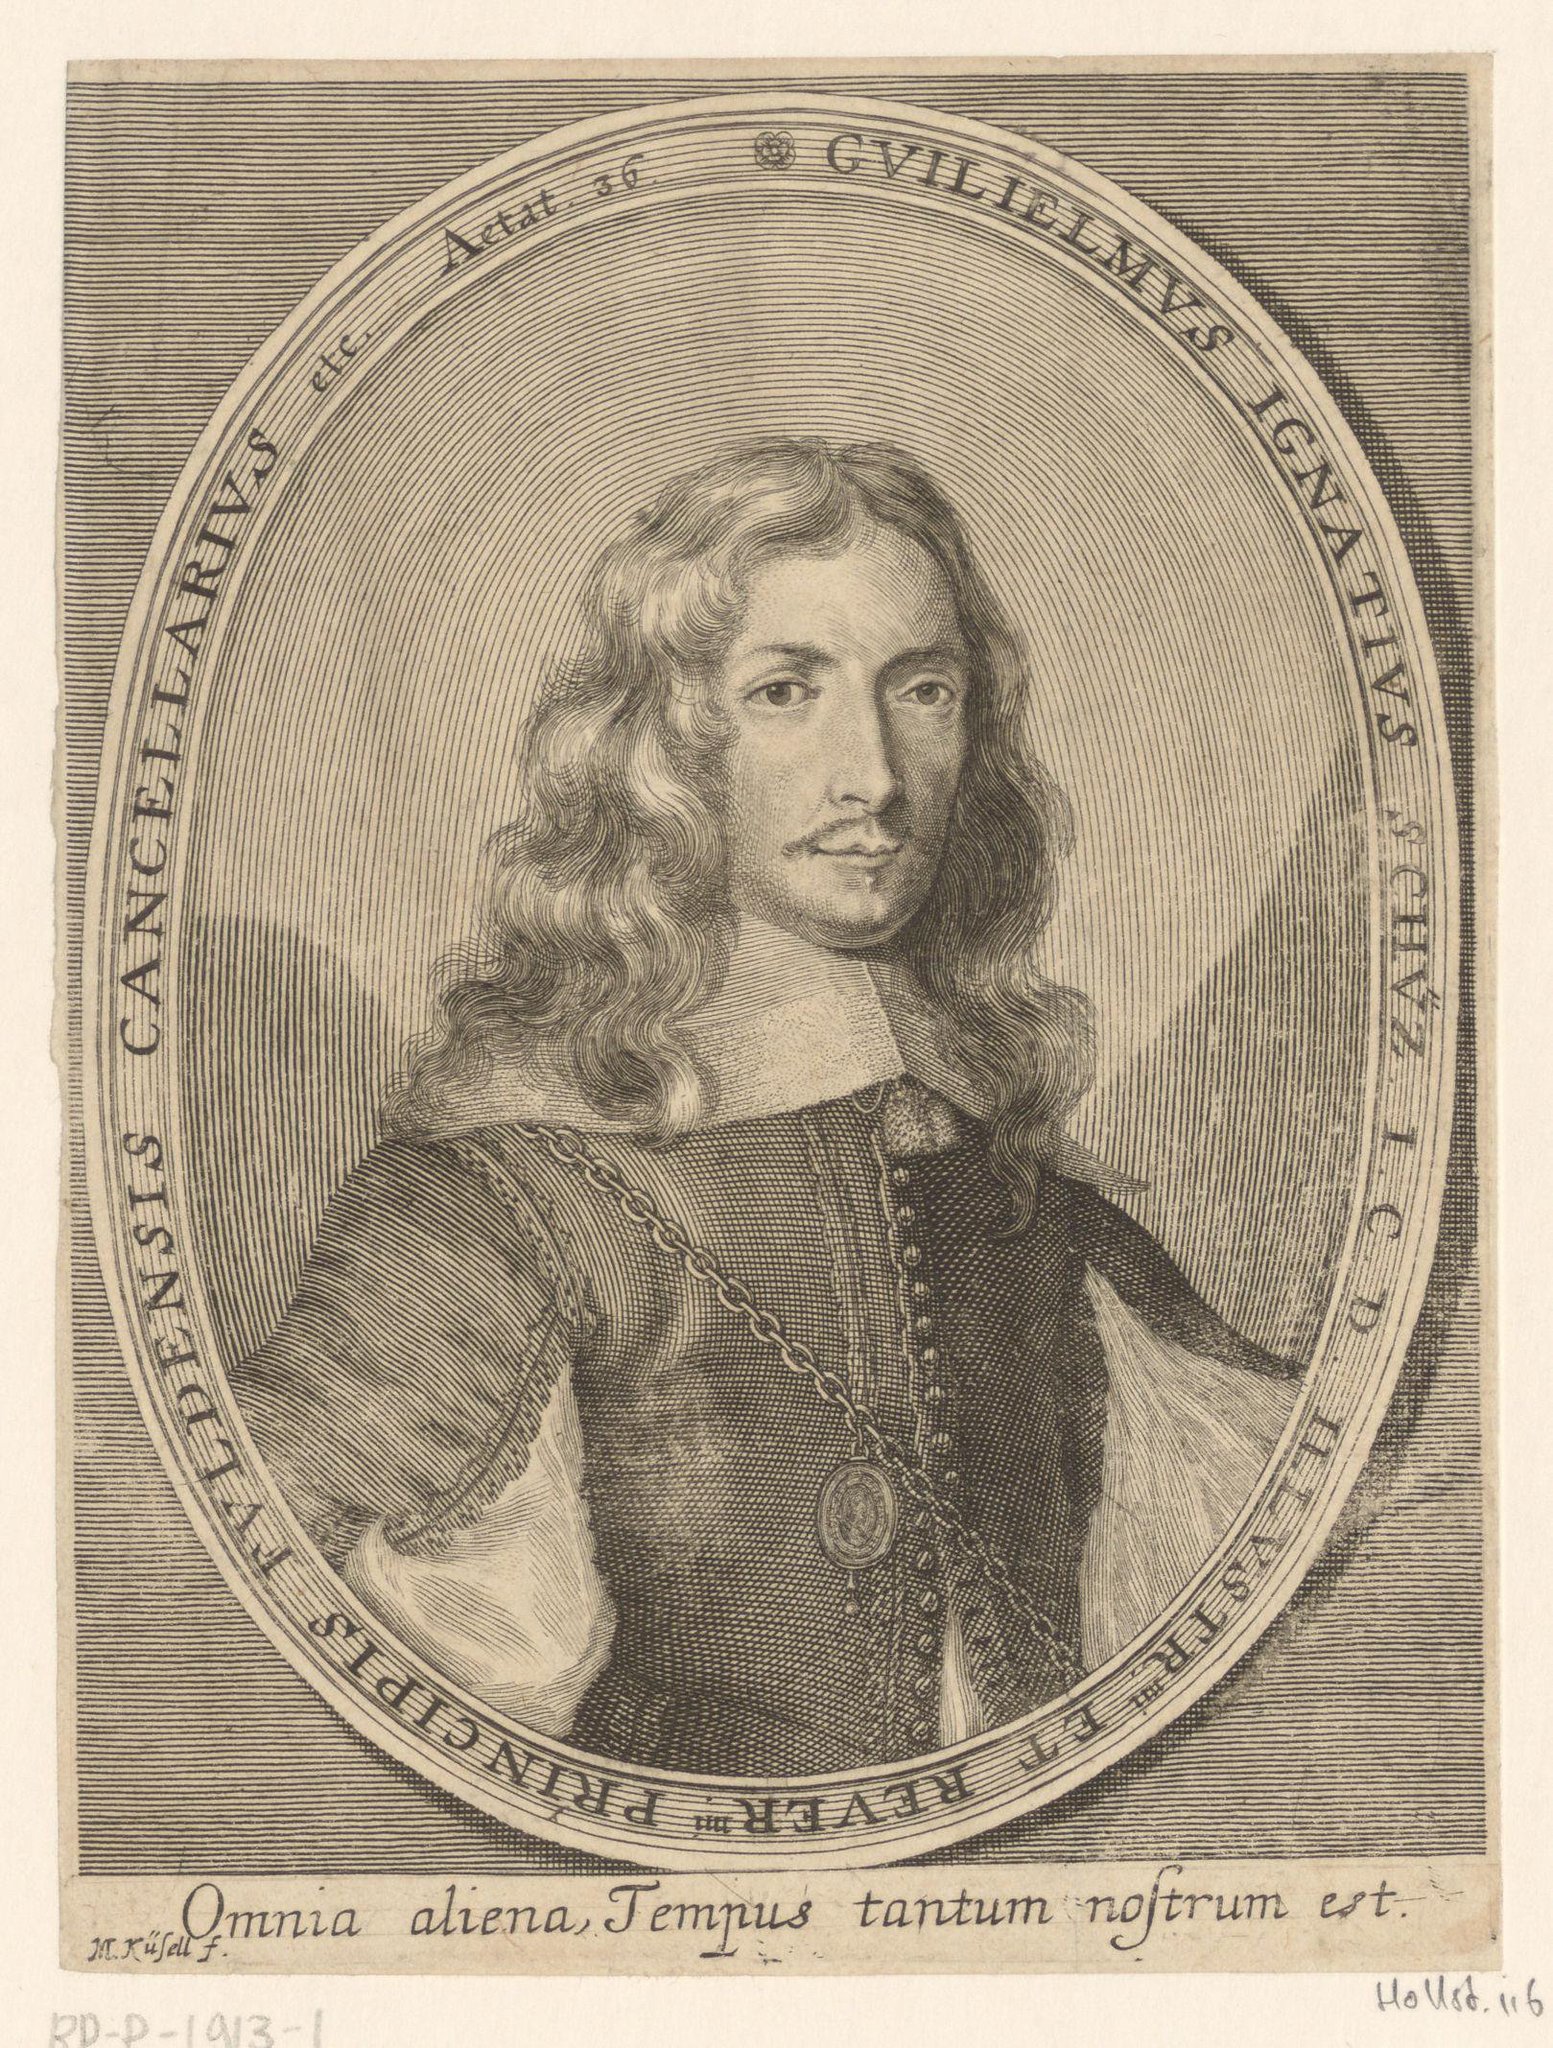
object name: print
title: Portret van Ignaz Wilhelm Schütz op 36-jarige leeftijd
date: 1661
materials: paper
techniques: engraving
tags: historical persons, politician, e.g. party leader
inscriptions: collector's mark: Lugt 2228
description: Tekst in het Latijn in de omlijsting en in de ondermarge.